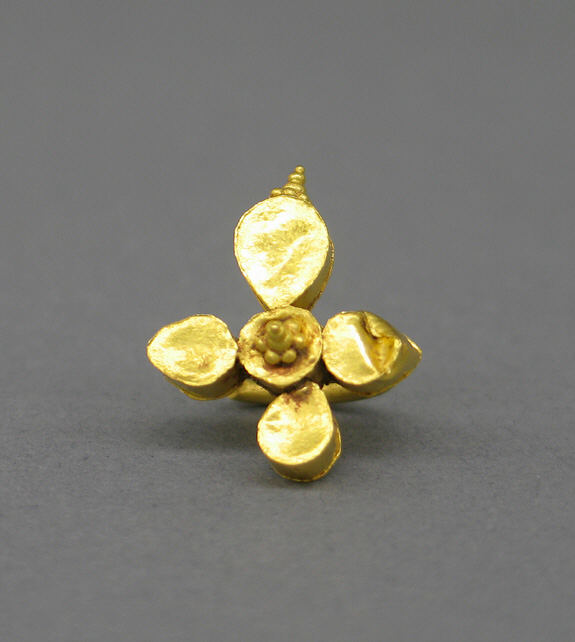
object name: ear clip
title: Pair of Ear clips in Quadrefoil Shape with Granulate Design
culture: indonesian, javanese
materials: gold